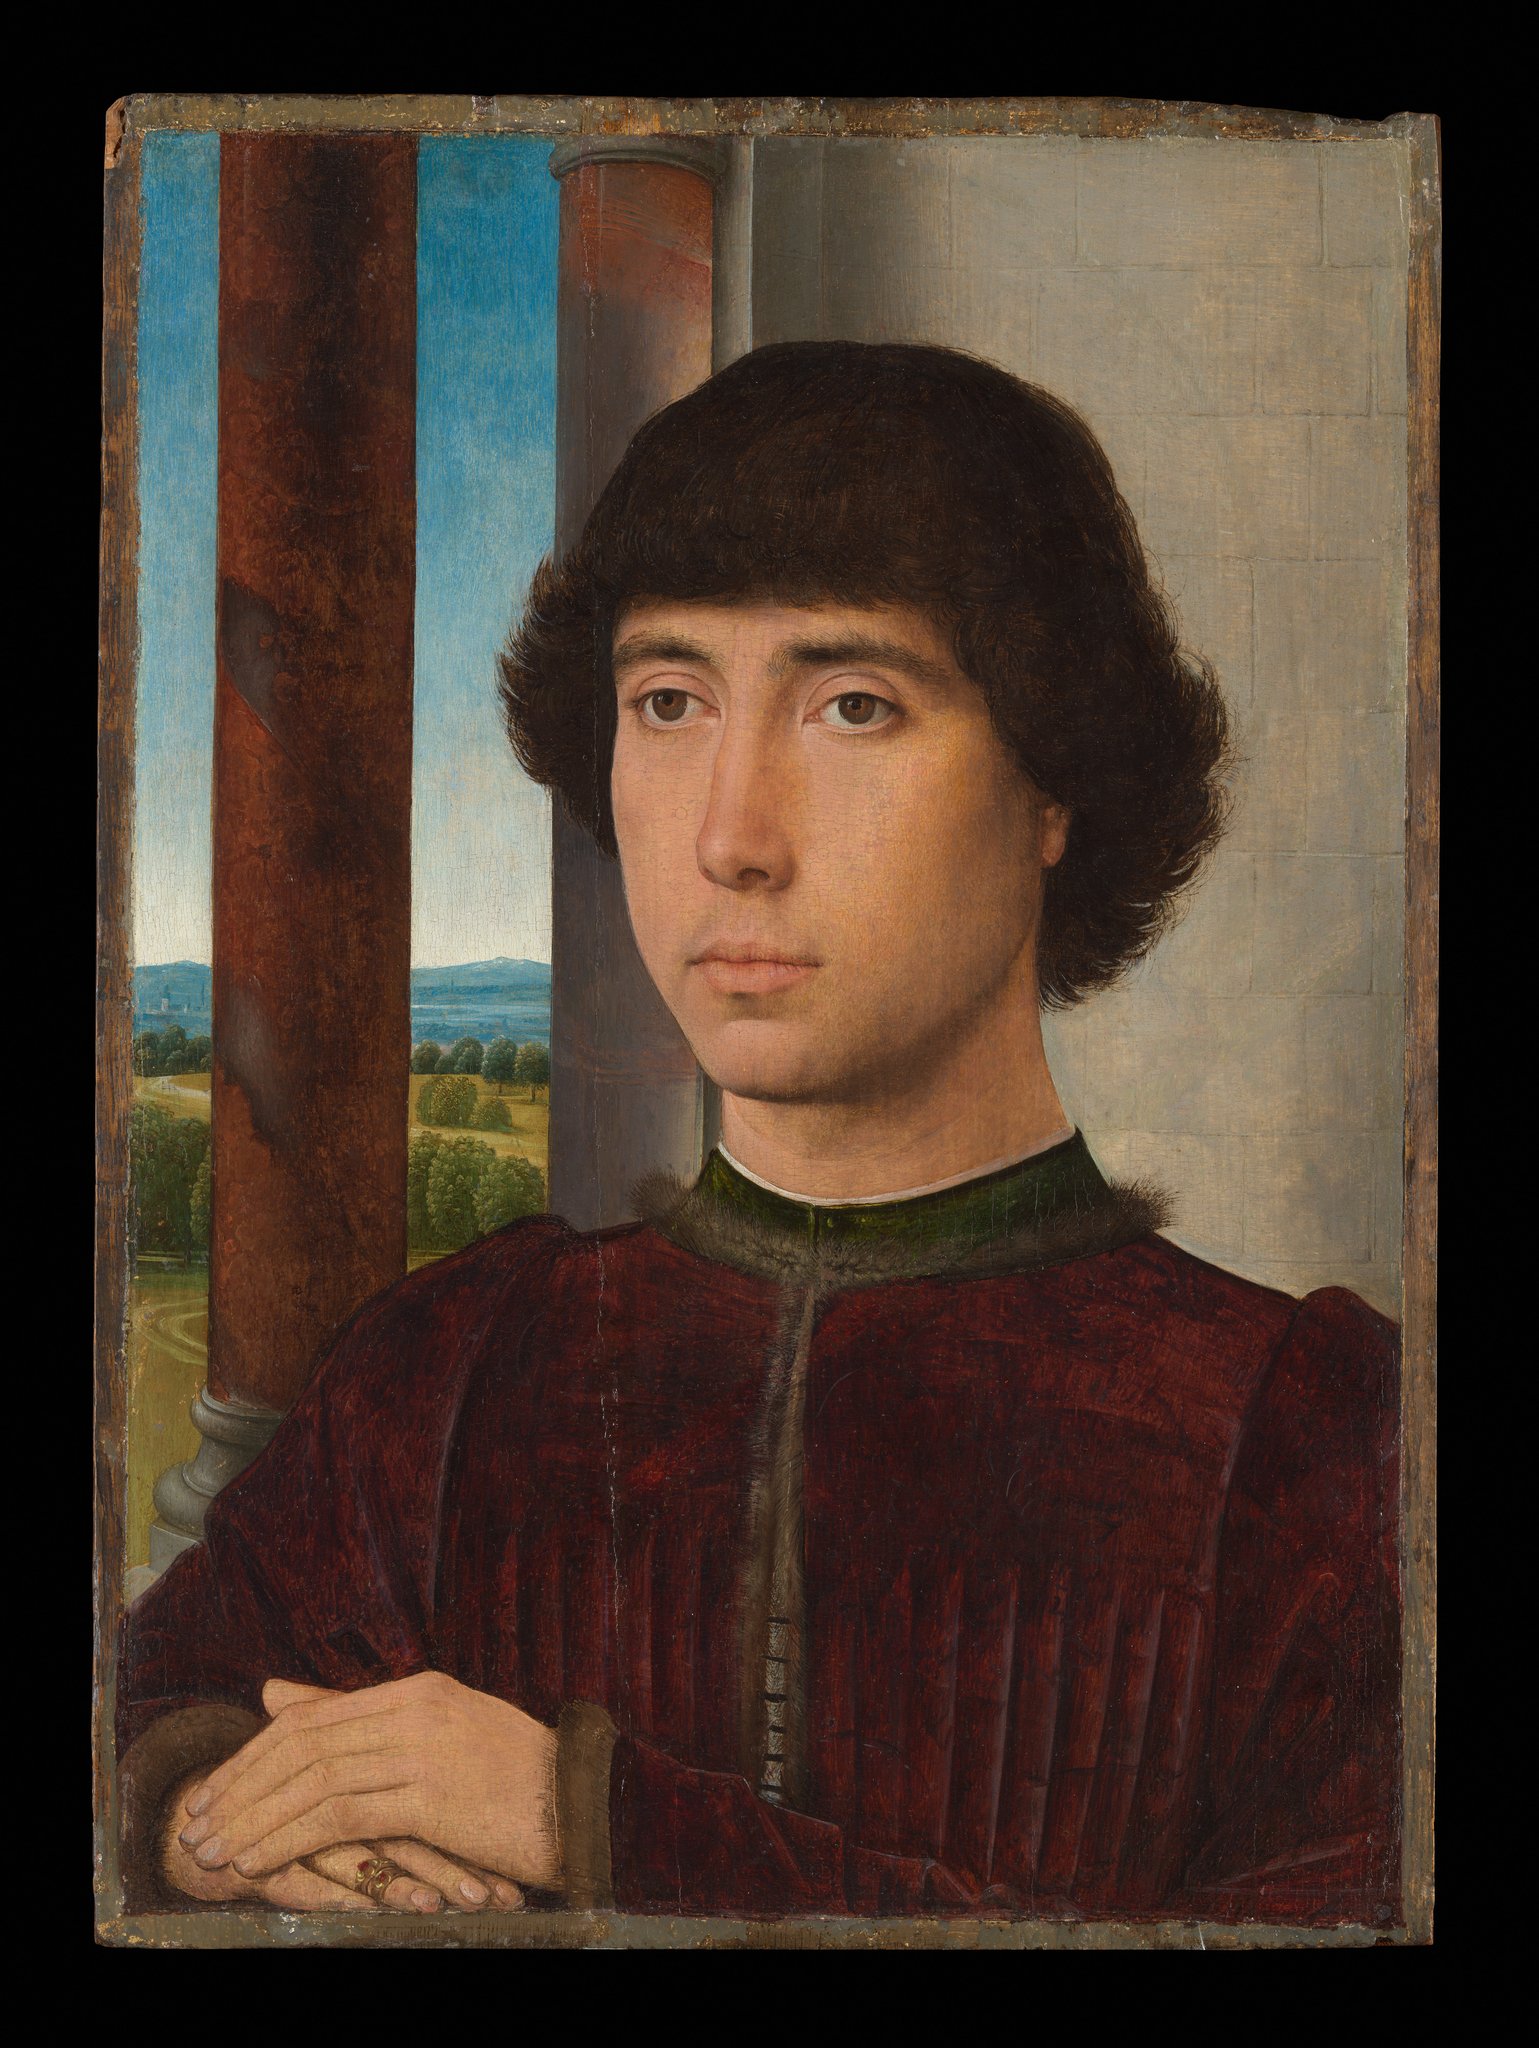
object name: painting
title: Portrait of a Young Man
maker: hans memling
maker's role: artist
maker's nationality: netherlandish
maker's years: 1465-1494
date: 1472-1475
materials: wood, oil, panel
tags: men,portraits